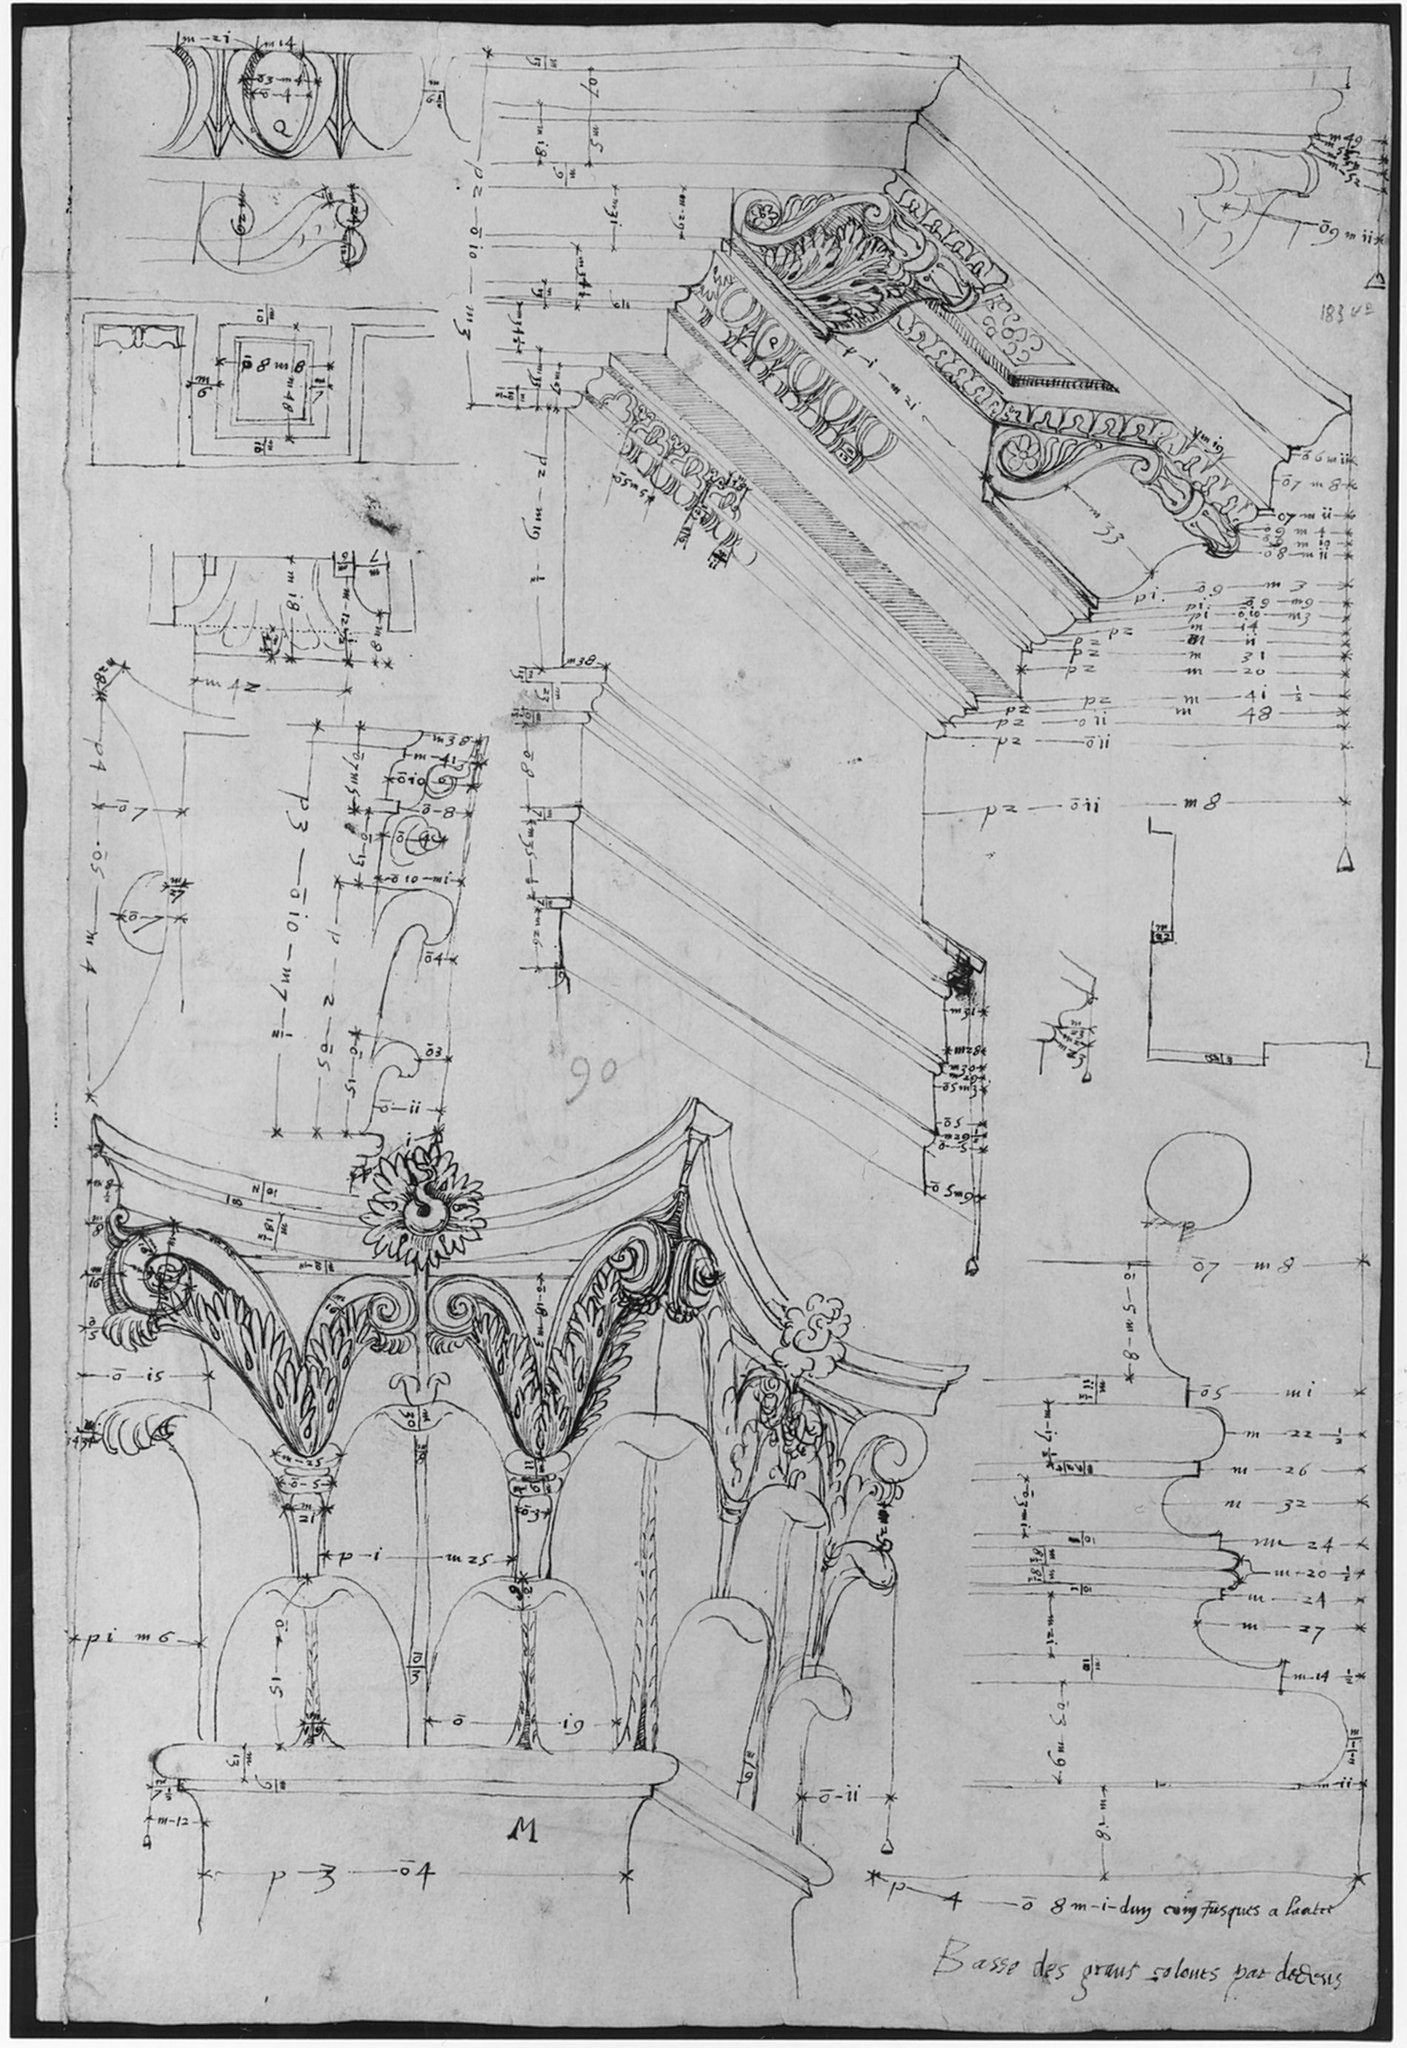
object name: collection ornament architecture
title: Pantheon, entablature and column pilaster capital, projection; rosette, details; capital profile; base, profile; pilaster, plan (recto) Pantheon, rectangular niche, perspective (verso)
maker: anonymous, french, 16th century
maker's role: draftsman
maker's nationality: french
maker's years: 1500-1600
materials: chalk, ink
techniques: incising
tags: architecture,capitals